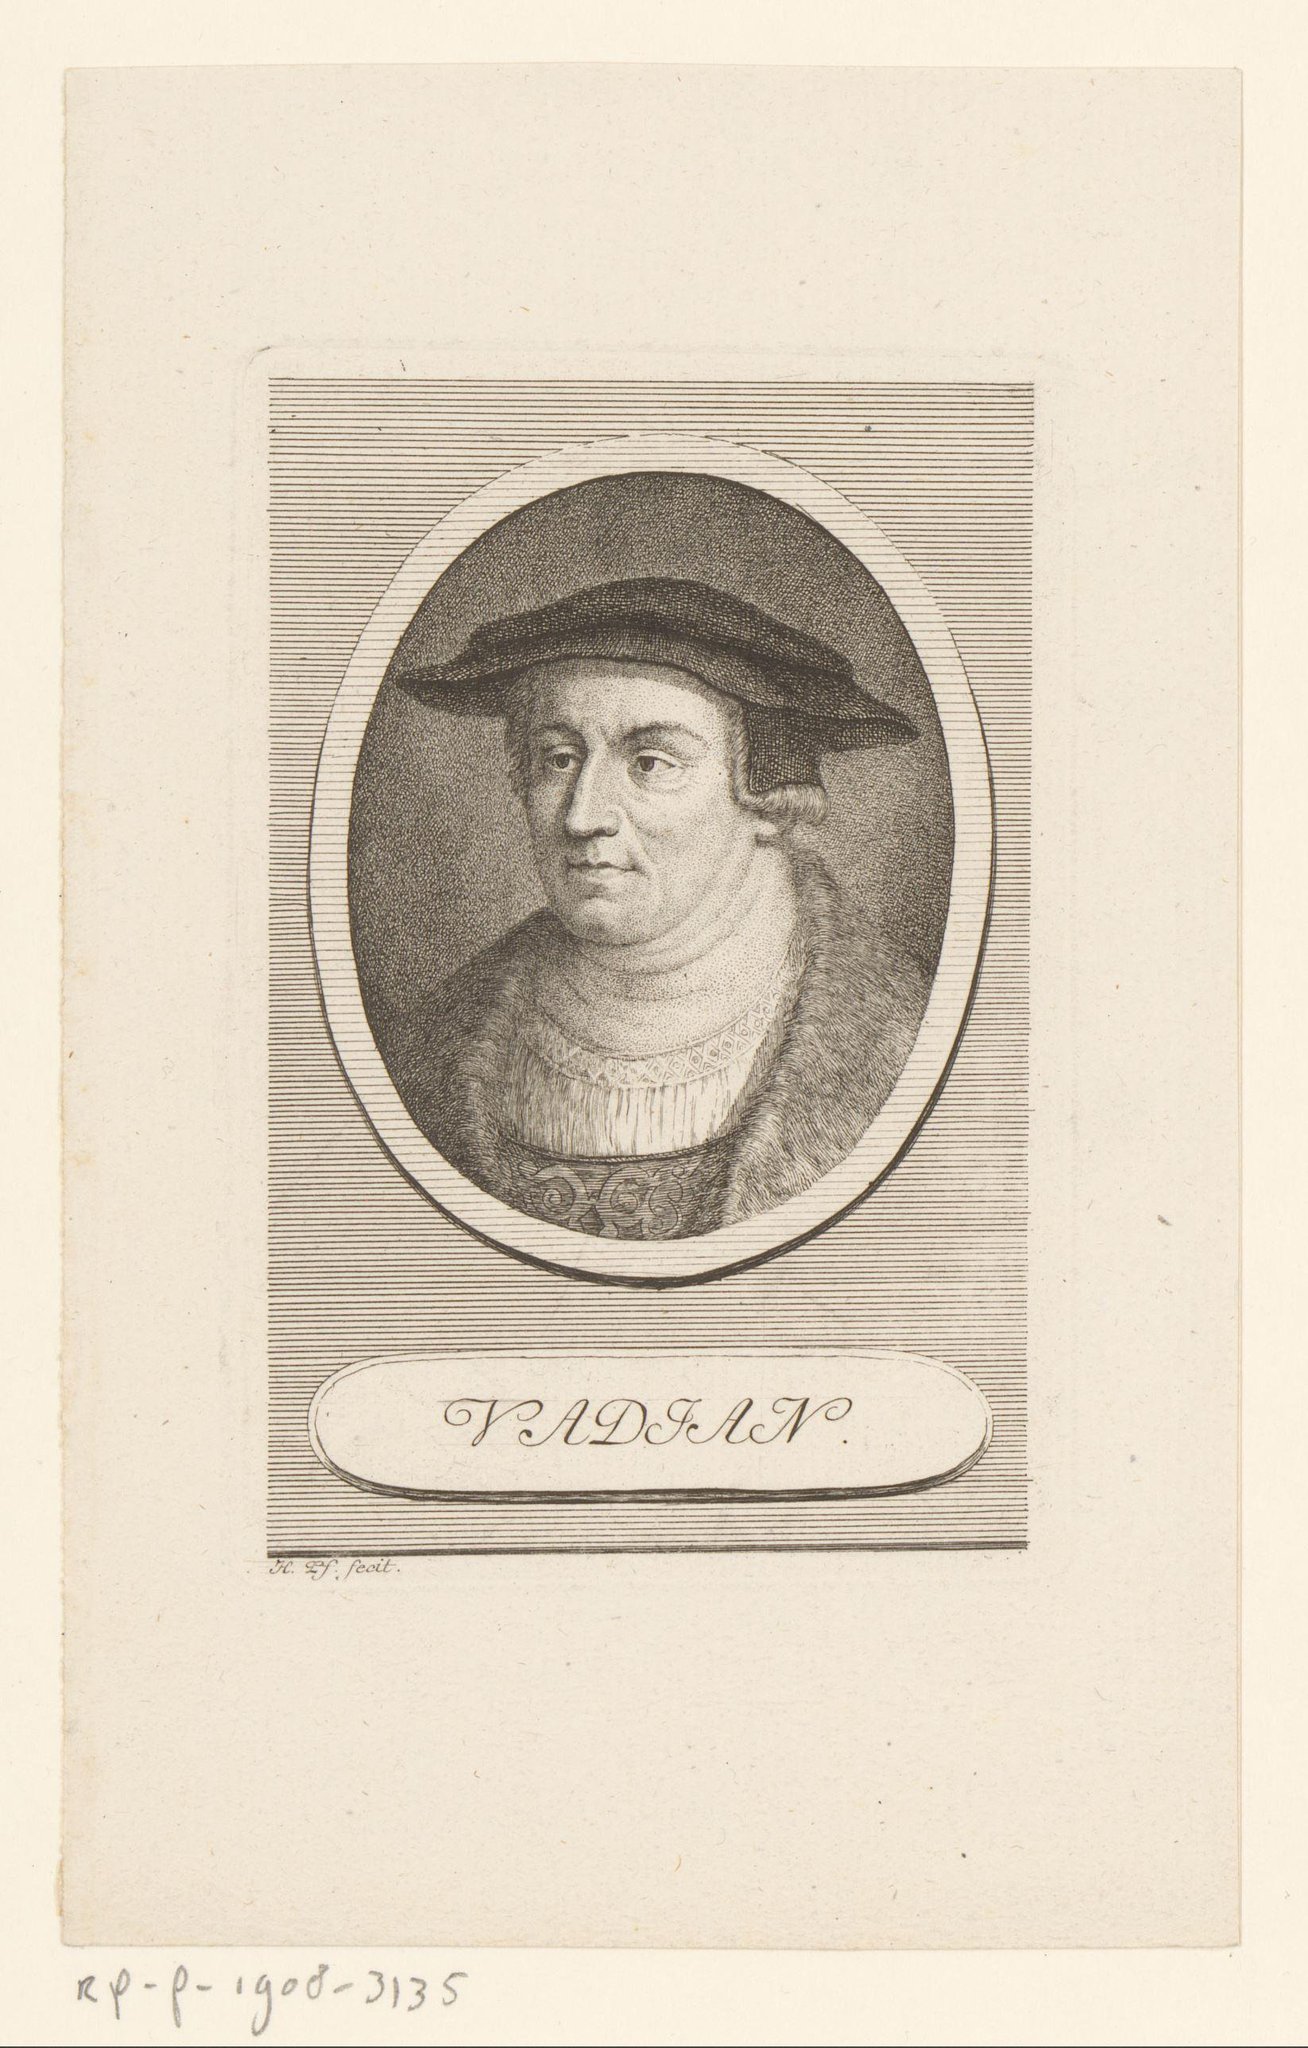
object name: print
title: Portret van Joachim de Watt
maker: heinrich pfenninger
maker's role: print maker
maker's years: 1749-1815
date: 1759-1815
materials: paper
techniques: etching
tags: mayor, historical persons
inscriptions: collector's mark: Lugt 2228